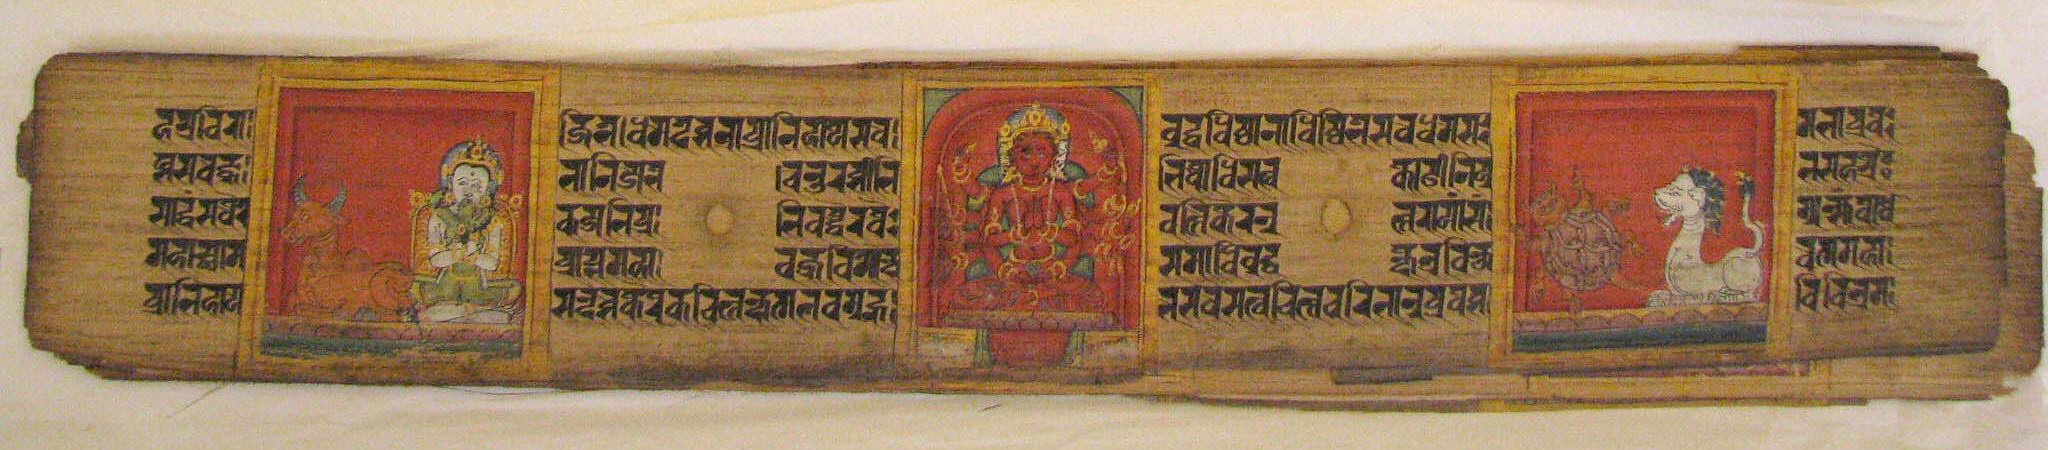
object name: folio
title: Leaf from an Illuminated Buddhist Manuscript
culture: nepali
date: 1301-1400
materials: ink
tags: buddhism,deities